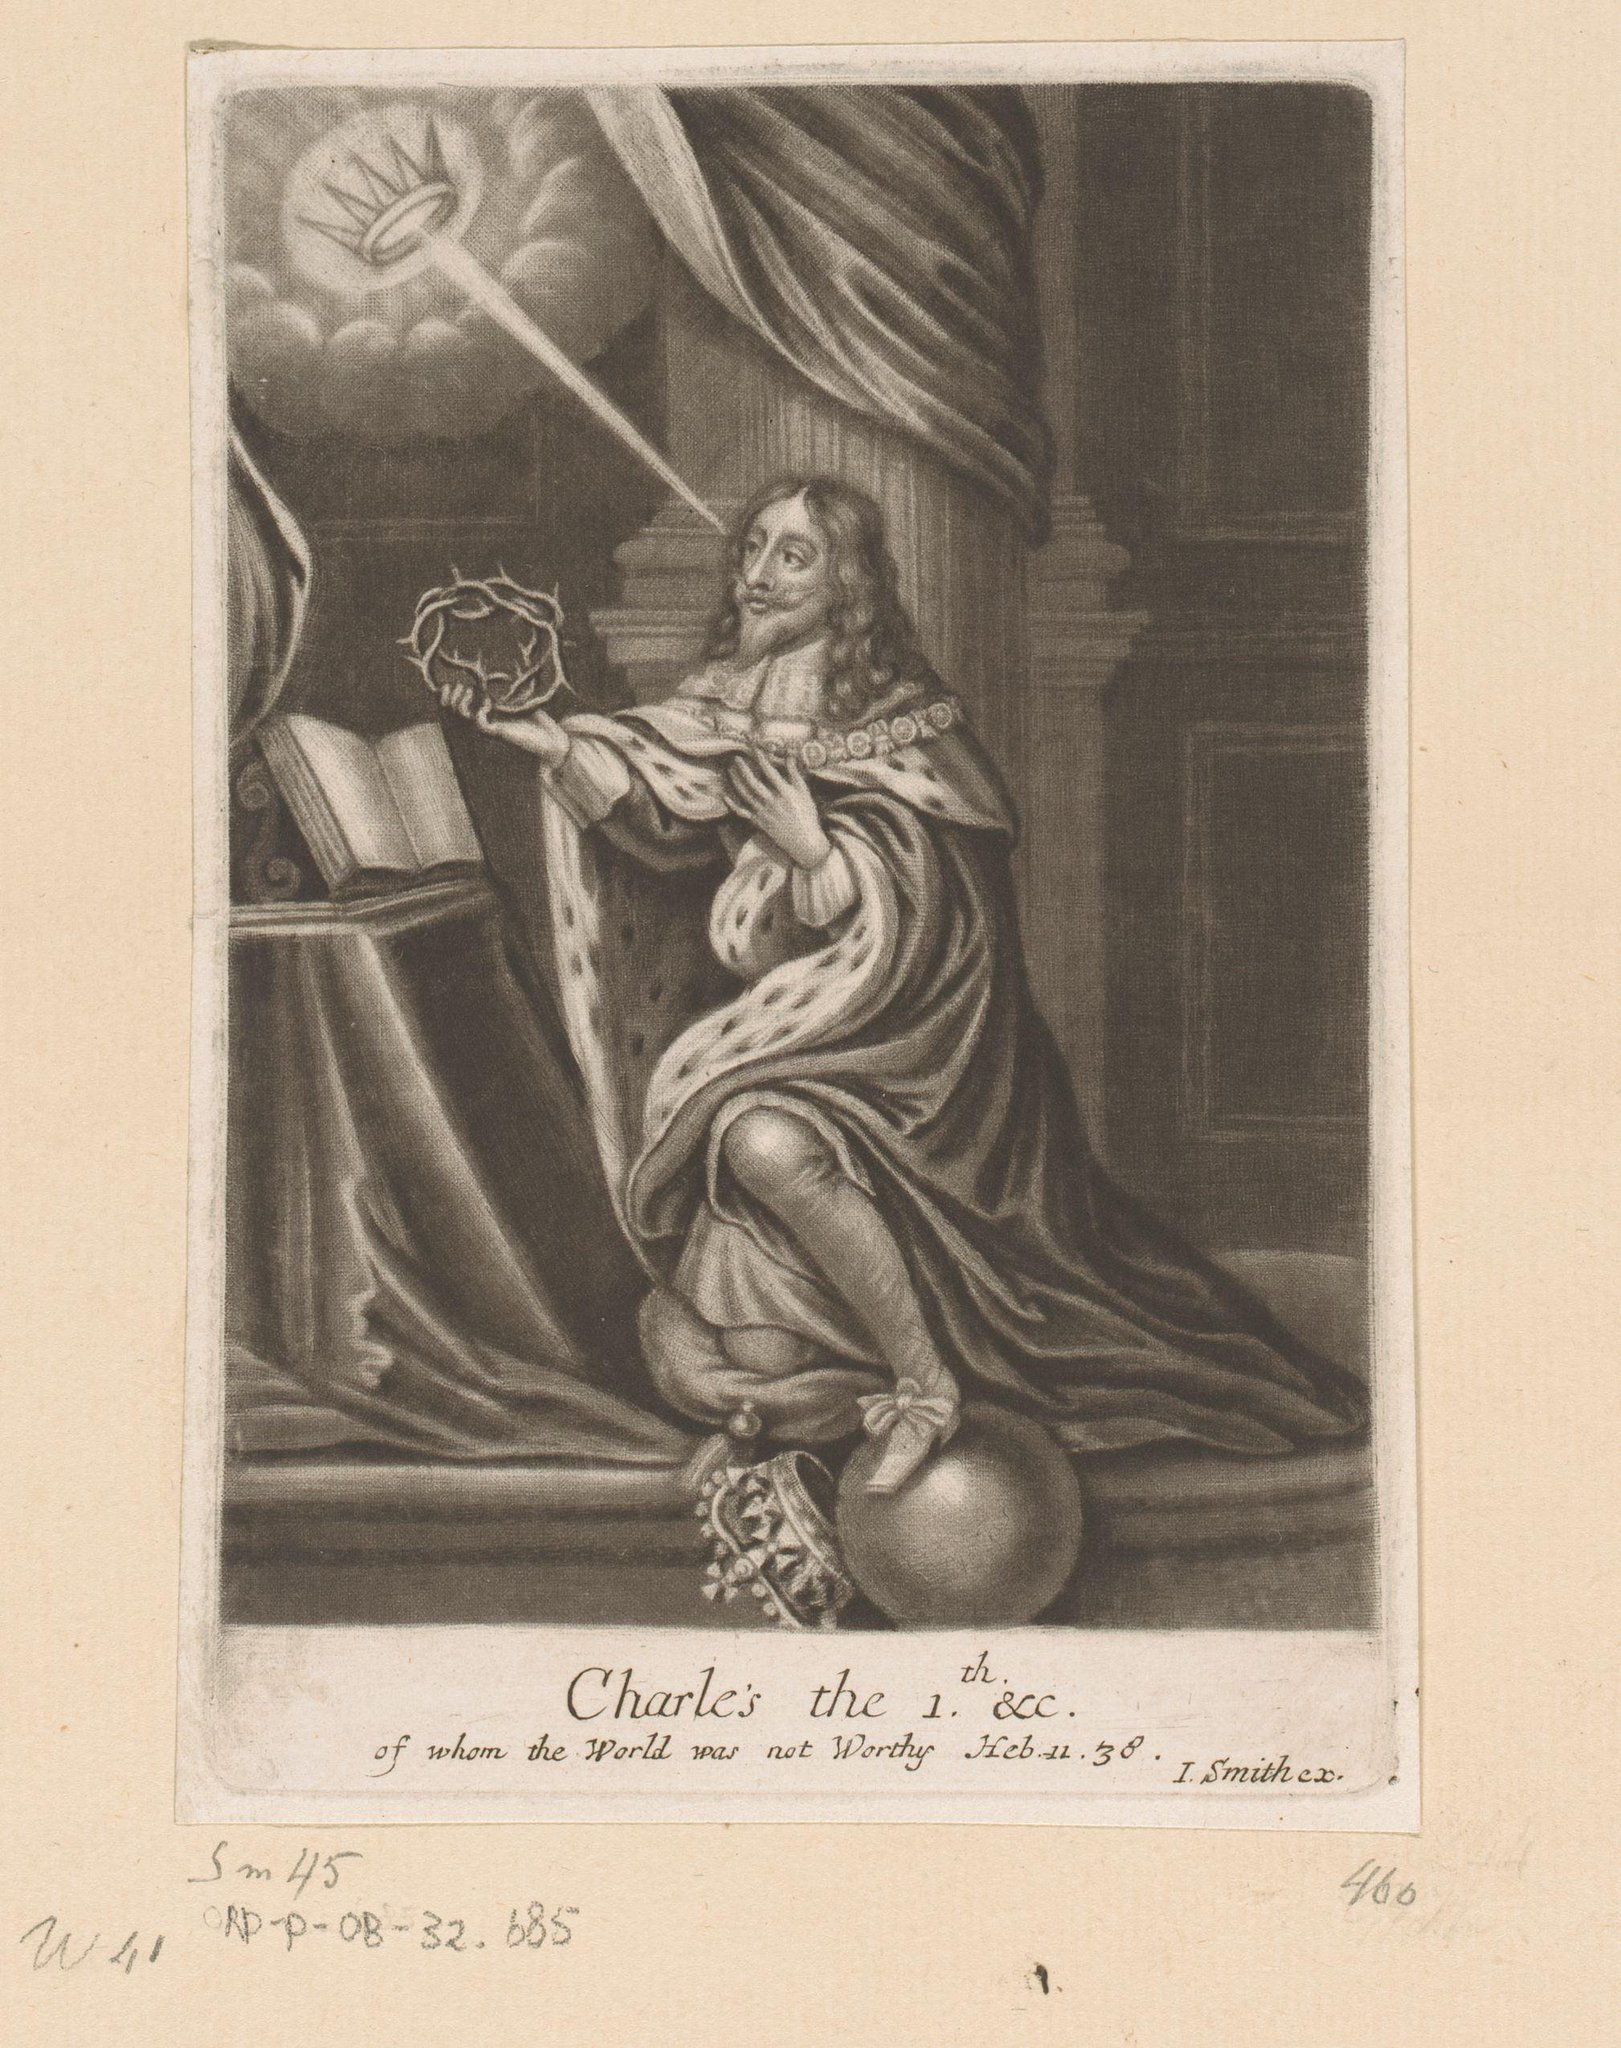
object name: print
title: Portret van Karel I, koning van Engeland geknield voor een altaar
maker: john smith (prentmaker/ uitgever)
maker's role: print maker, publisher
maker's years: 1652-1743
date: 1662-1742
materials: paper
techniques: mezzotint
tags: london, karel i (koning van engeland), crown (symbol of sovereignty), historical persons, crown of thorns ~ instruments of the passion, king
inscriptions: collector's mark: Lugt 240